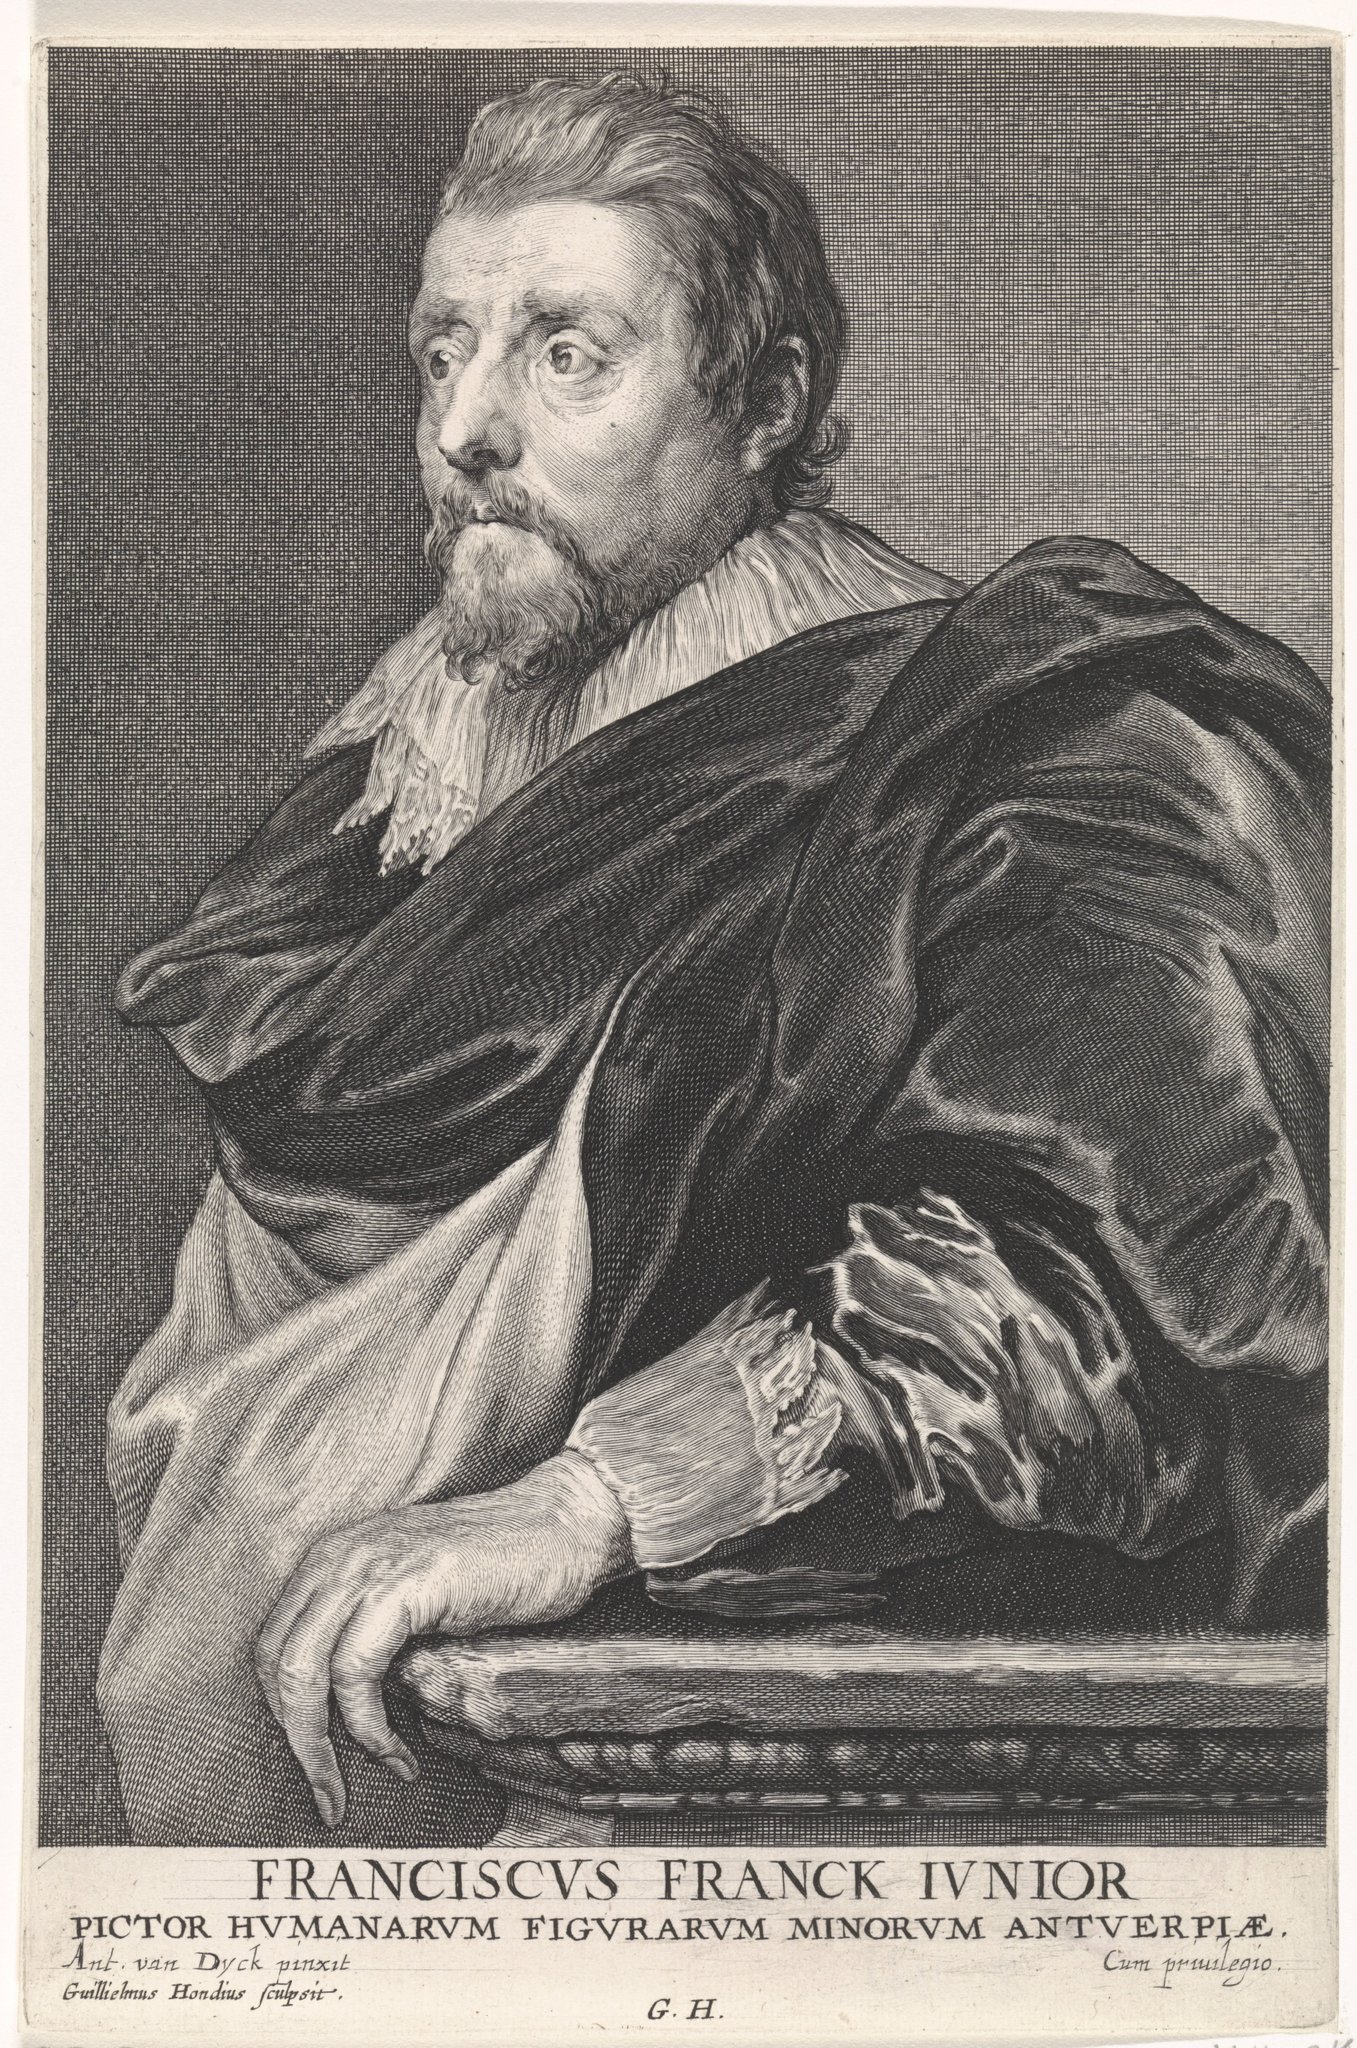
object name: print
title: Portret van Frans Francken (II)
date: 1628-1670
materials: paper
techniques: engraving, etching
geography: antwerp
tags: antwerp, draughtsman, frans francken (ii)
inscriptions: collector's mark: Lugt 240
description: Portret van de kunstenaar Frans Francken (II), ten halven lijve. Met zijn linkerhand leunt hij op een tafel. In de marge de naam van de geportretteerde en een onderschrift in het Latijn.